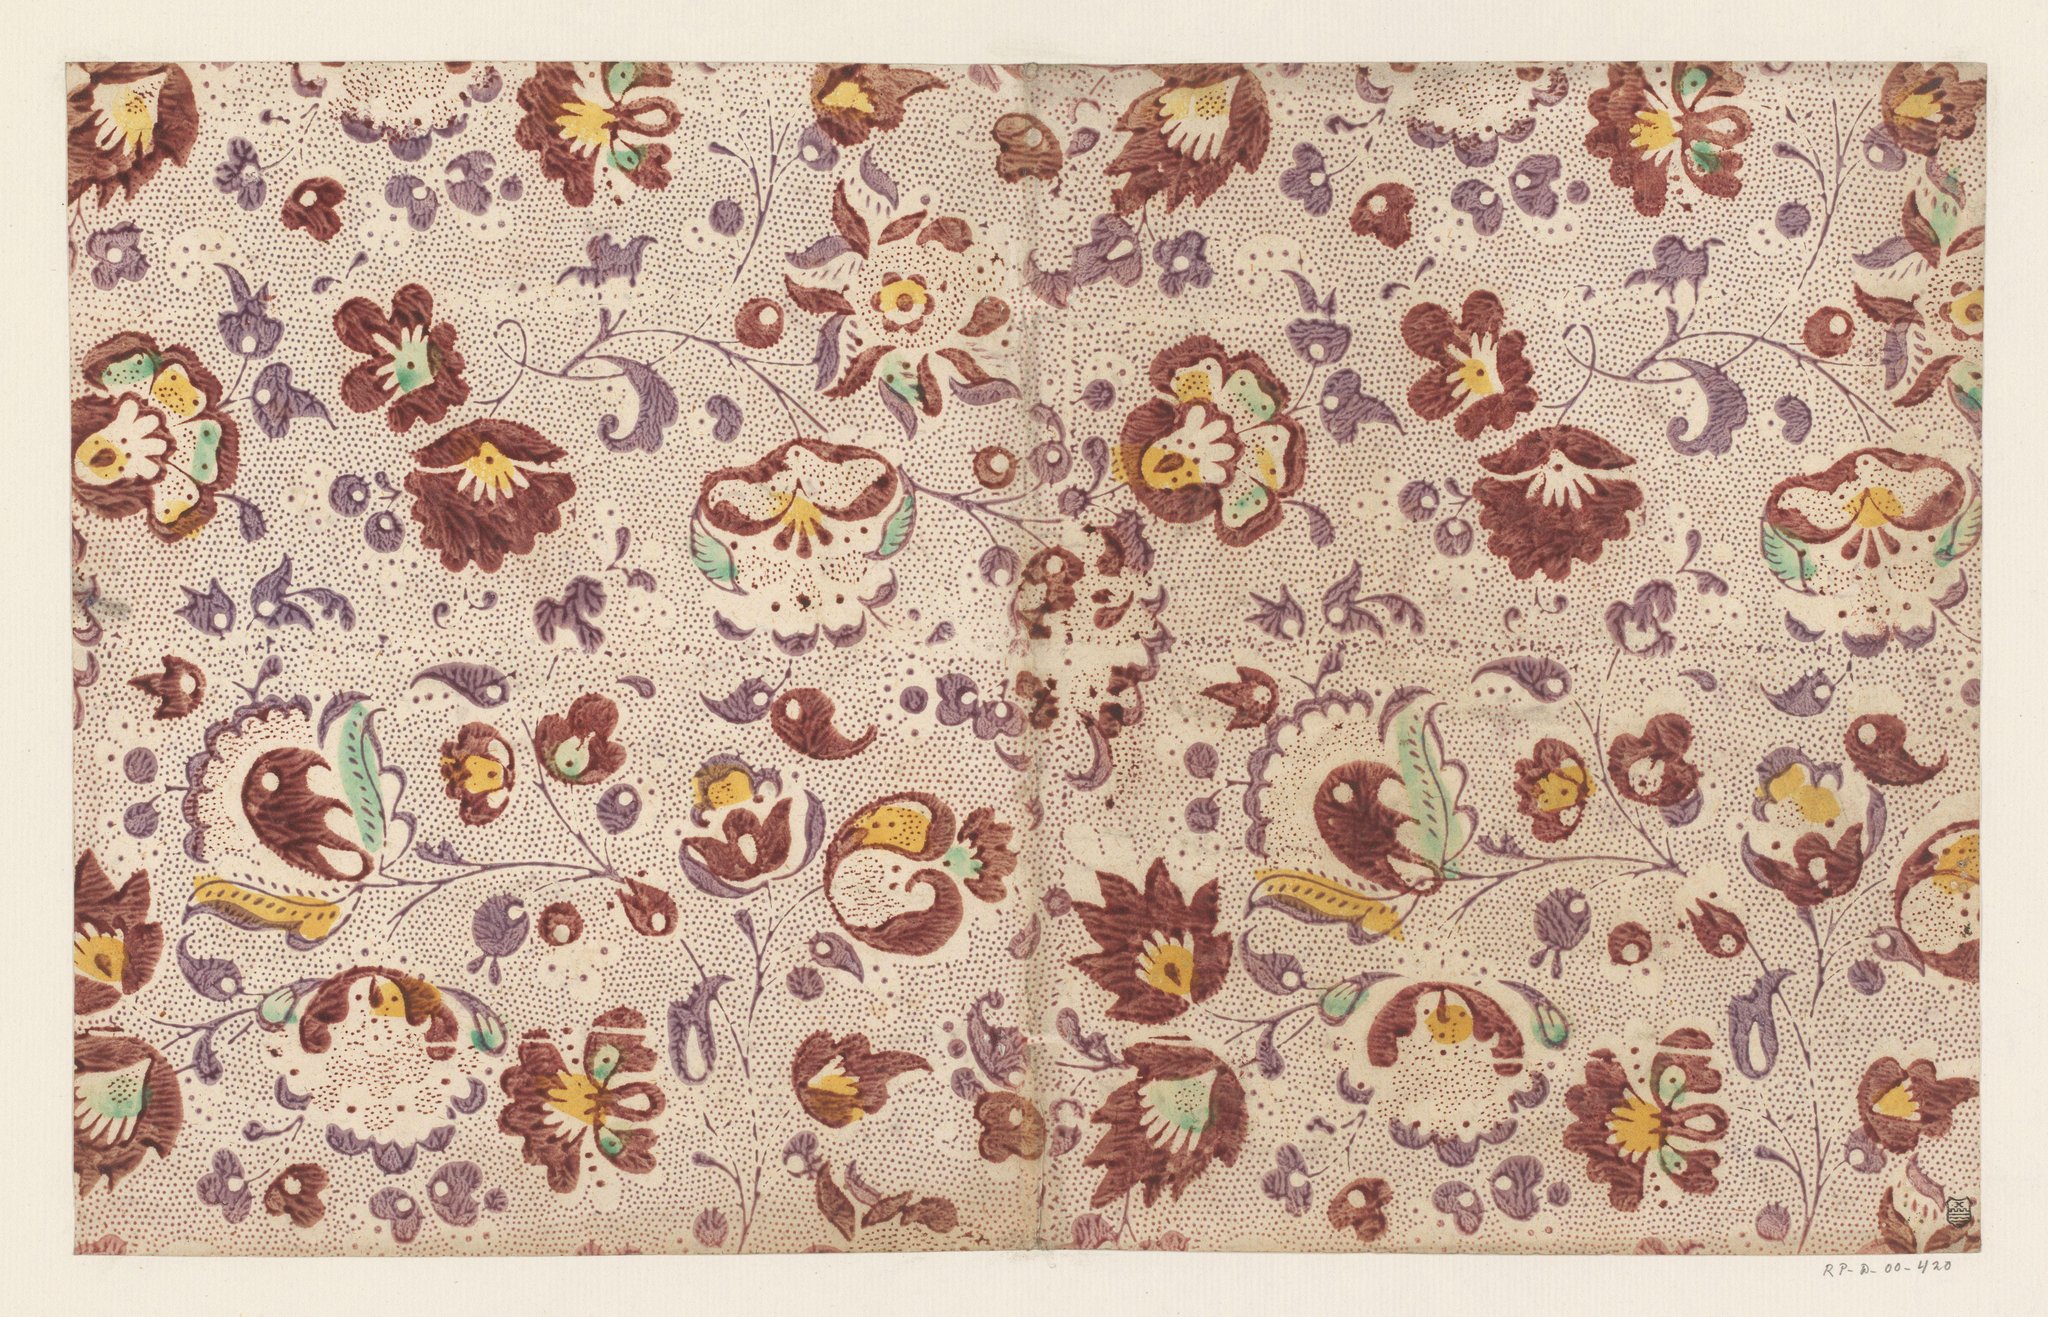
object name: printed paper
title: Blad met strooipatroon van ranken met bloemen en vruchten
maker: Anonymous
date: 1700-1850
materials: paper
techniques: printing block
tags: ornament derived from plant forms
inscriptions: collector's mark: Lugt 2760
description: Blad met strooipatroon van ranken met bloemen en vruchten een puntenfond, blokafdrukken zichtbaar. Gebruikt als omslag.